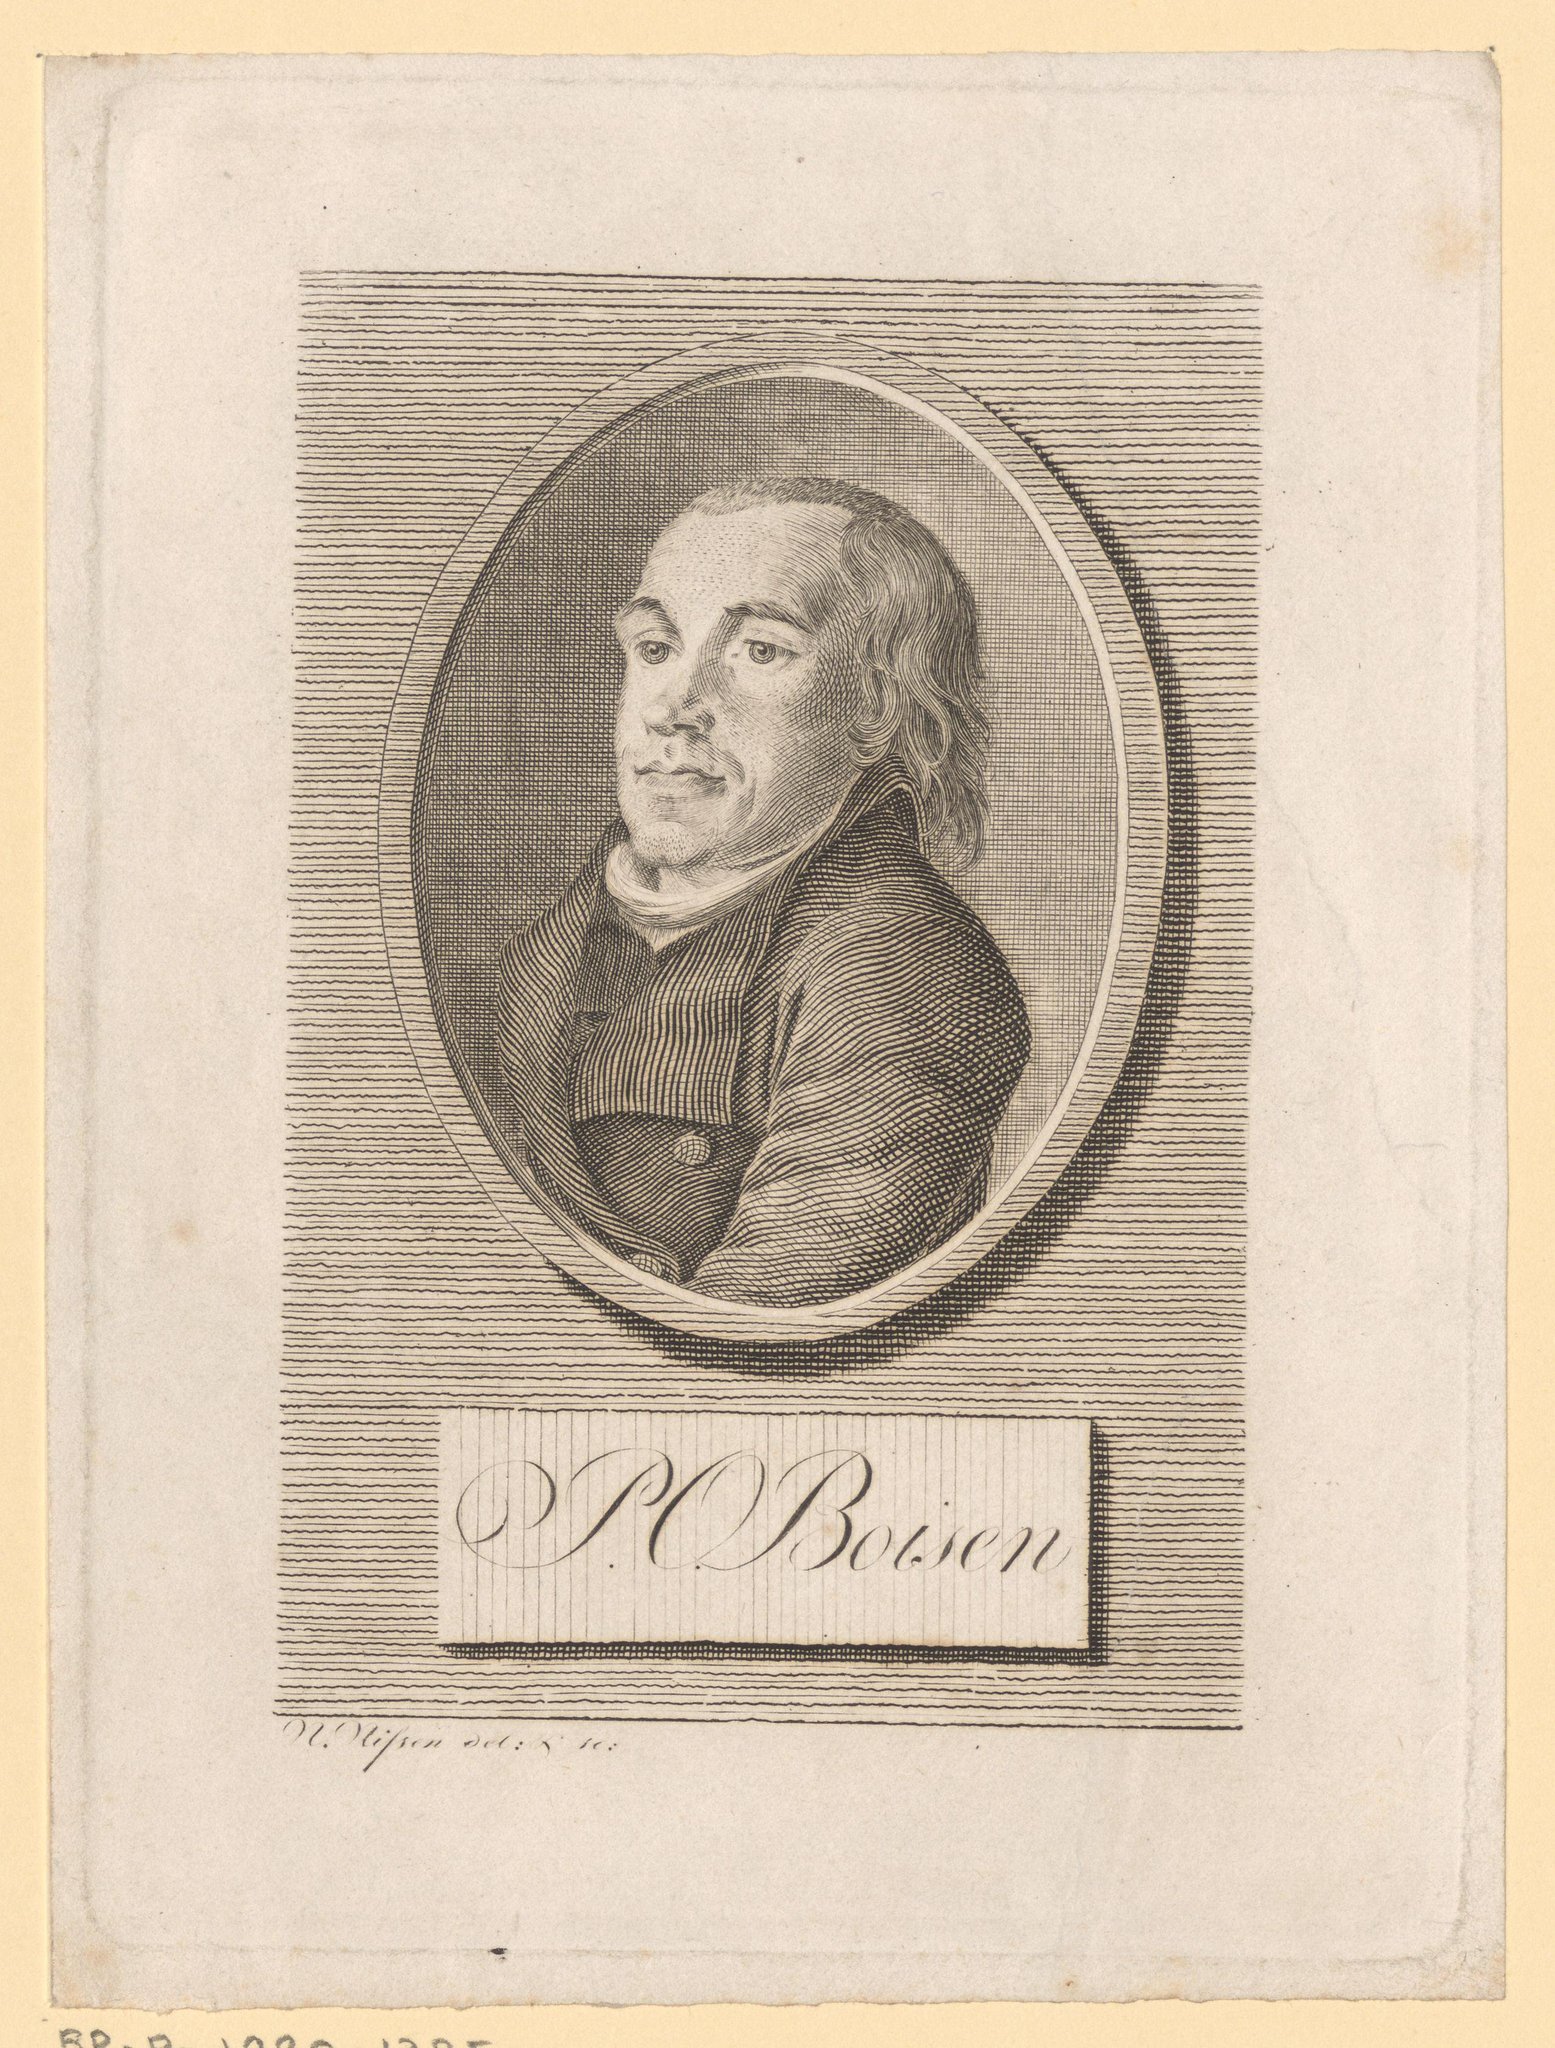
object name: print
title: Portret van Peter Outzen Boisen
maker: n. nissen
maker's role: print maker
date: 1800-1849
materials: paper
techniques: engraving, etching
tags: archbishop, bishop, etc. (roman catholic), historical persons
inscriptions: collector's mark: Lugt 2228